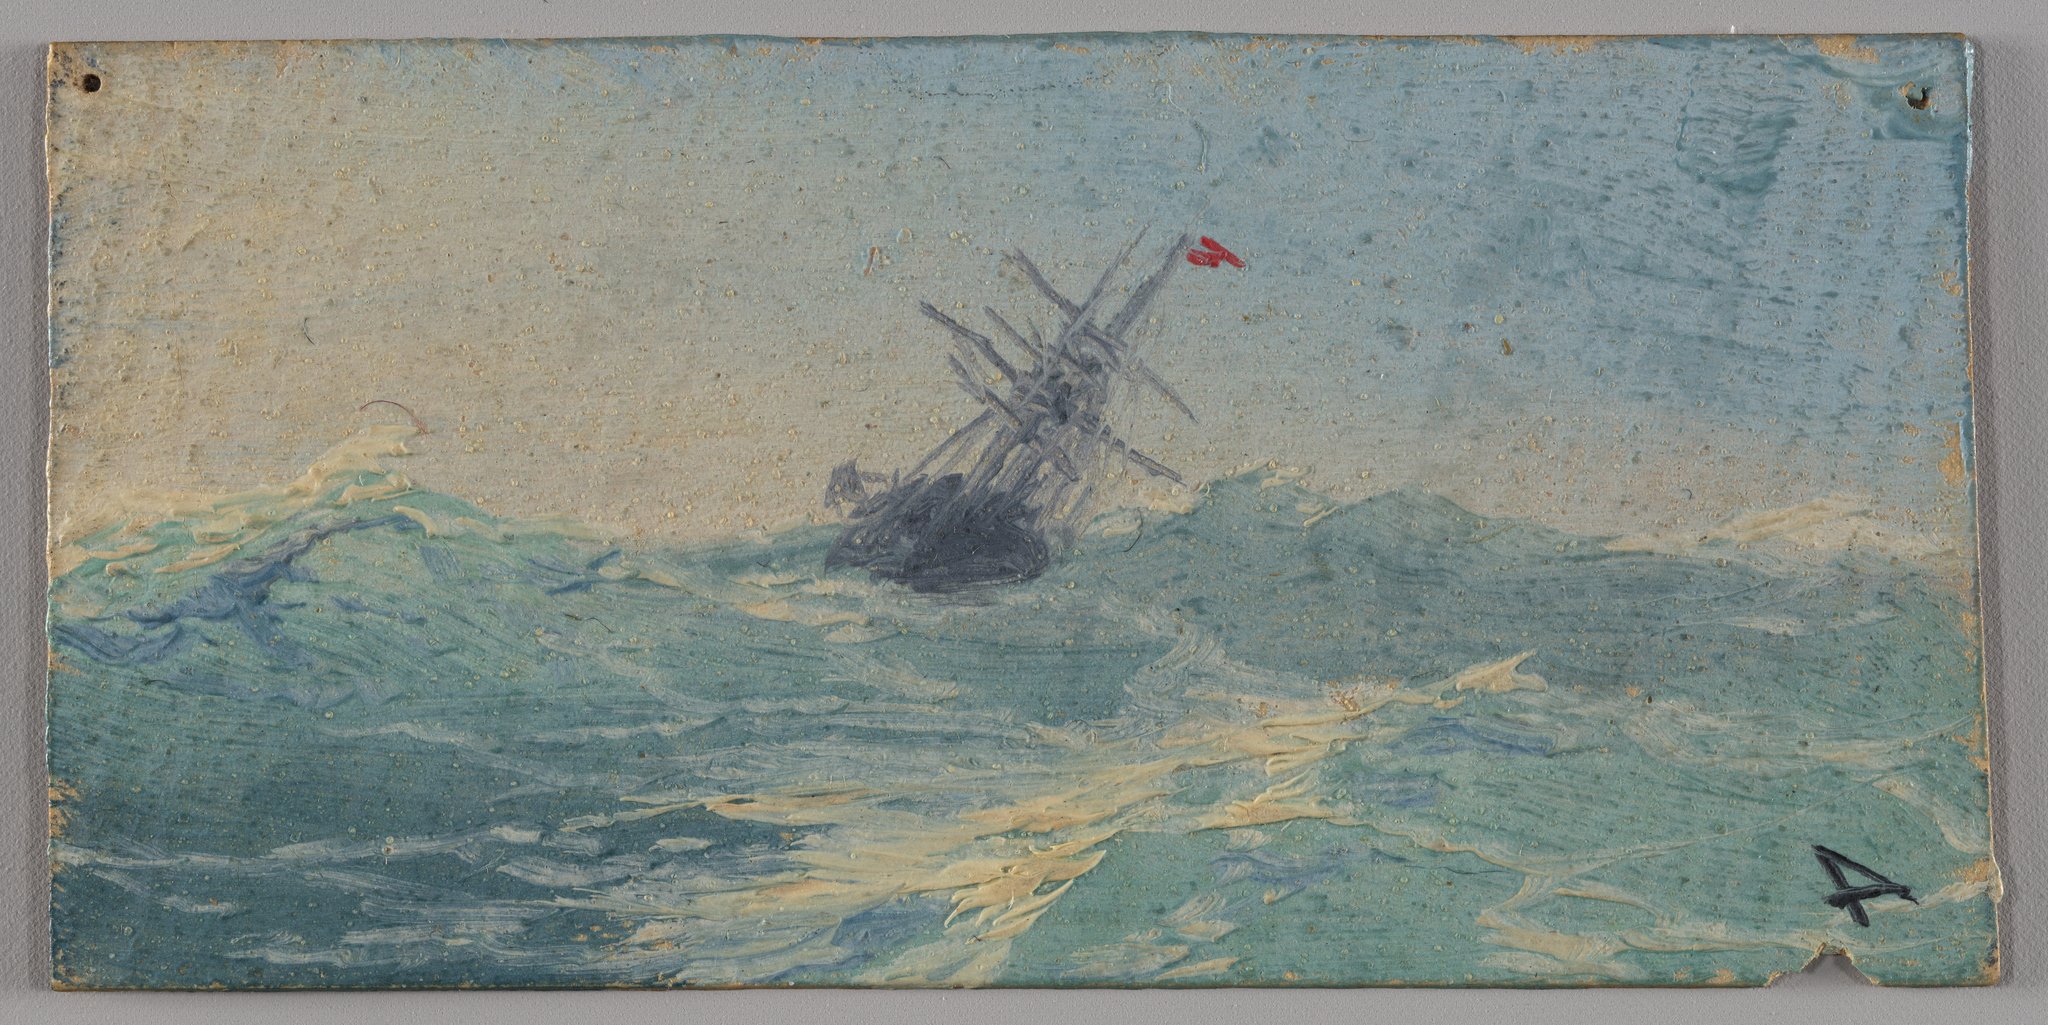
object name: painting, miniature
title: A Ship in a Stormy Sea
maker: ivan konstantinovich aivazovsky (hovhannes aivazian)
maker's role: artist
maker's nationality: armenian, born russian empire [now ukraine]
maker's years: 1817-1900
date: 1892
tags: seas,storms,ships